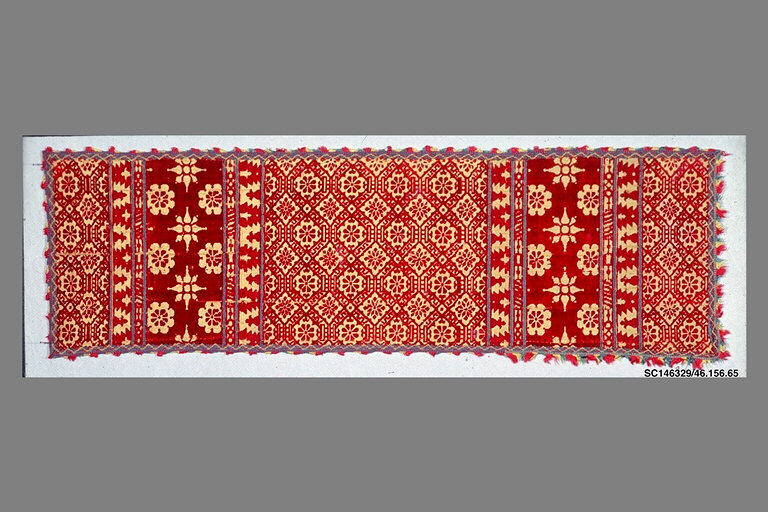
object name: piece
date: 1501-1600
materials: silk